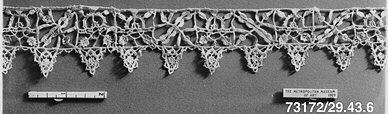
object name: strip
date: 1601-1633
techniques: lace